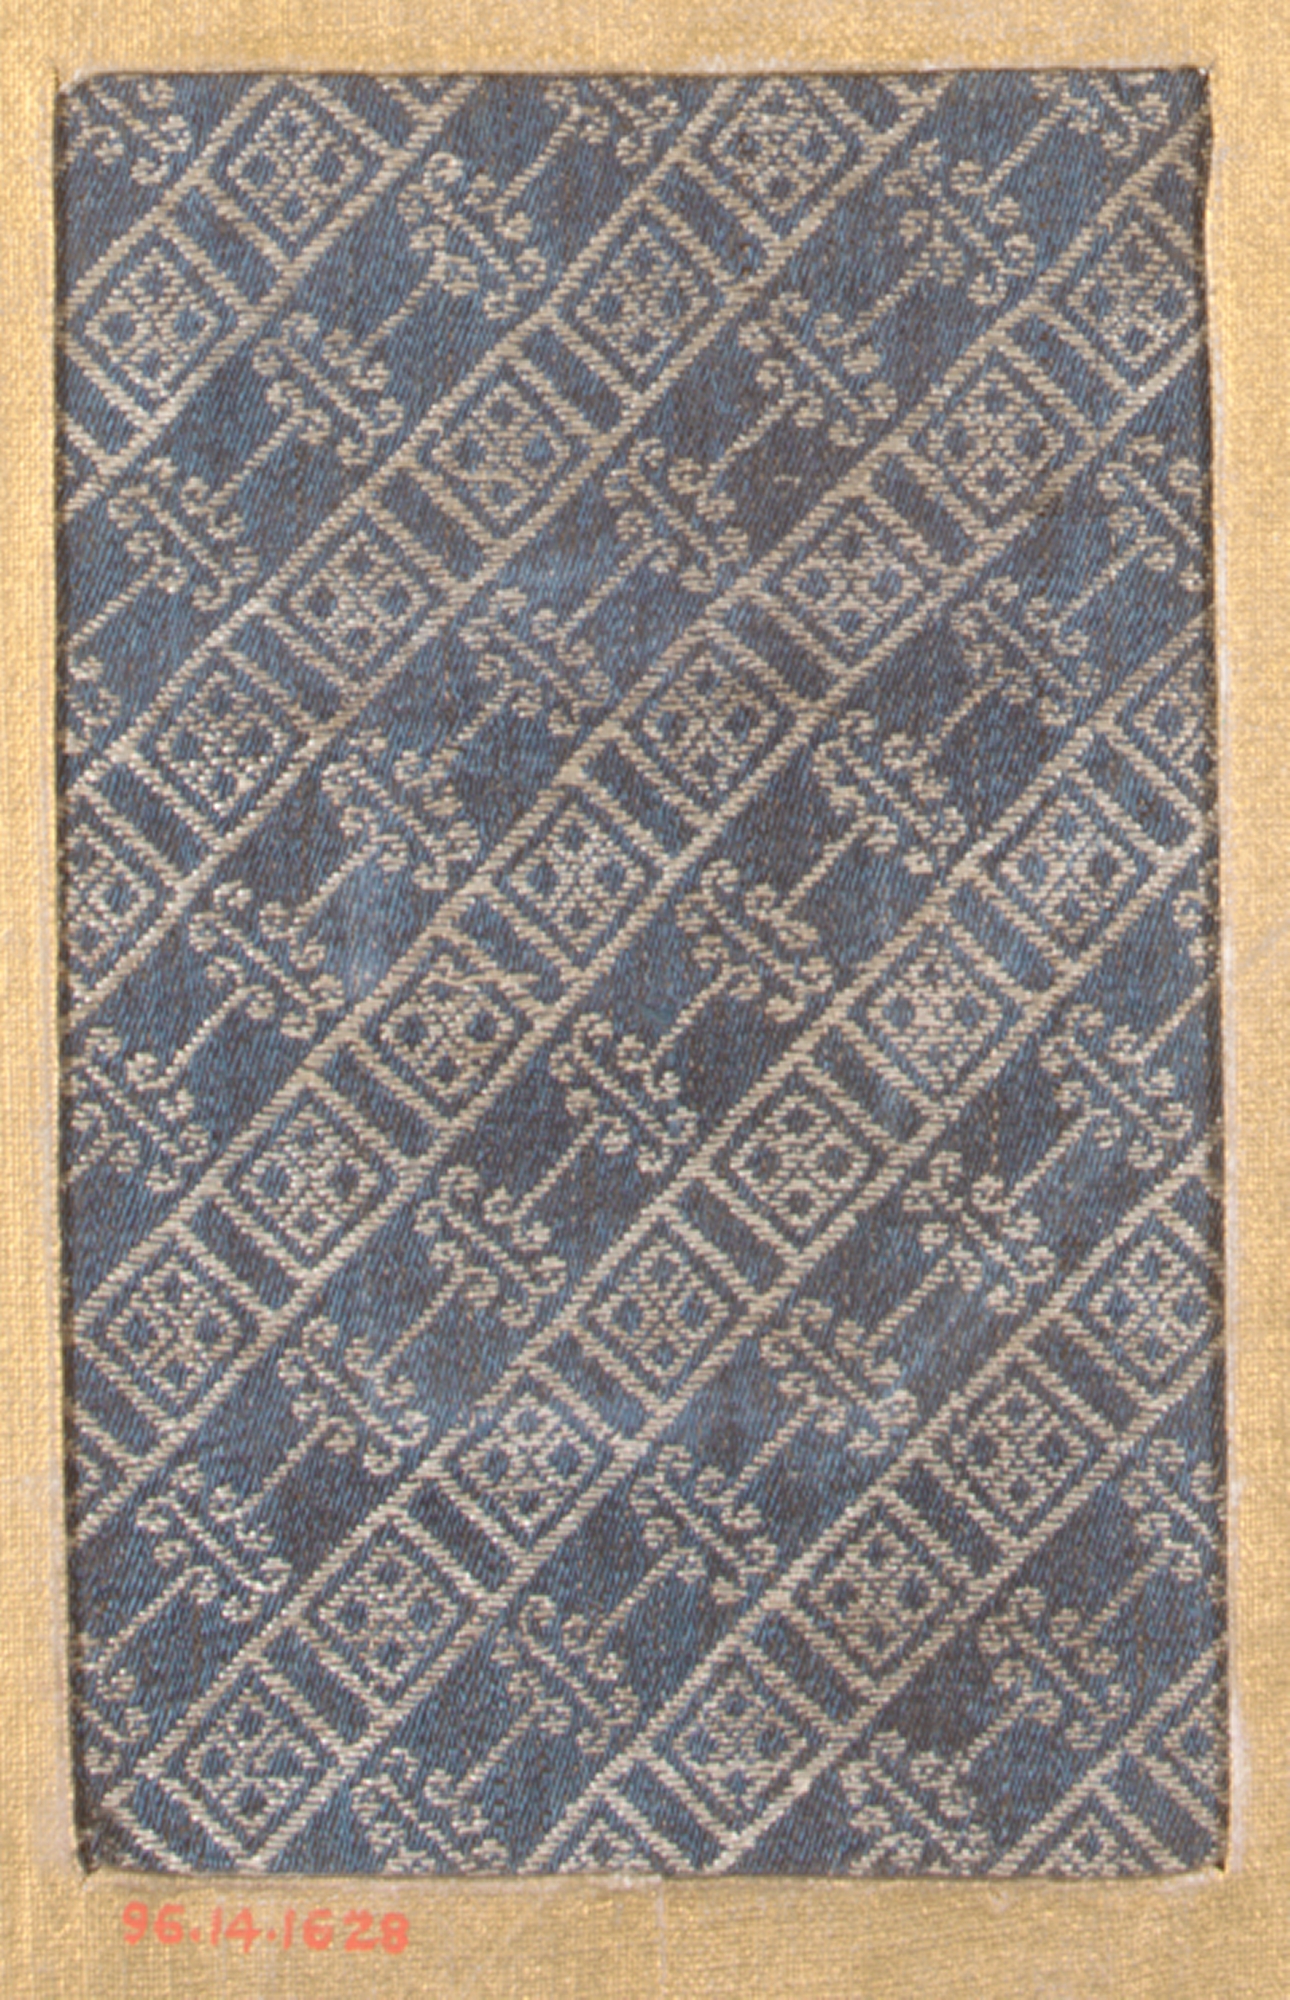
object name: piece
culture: japanese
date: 1701-1900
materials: silk